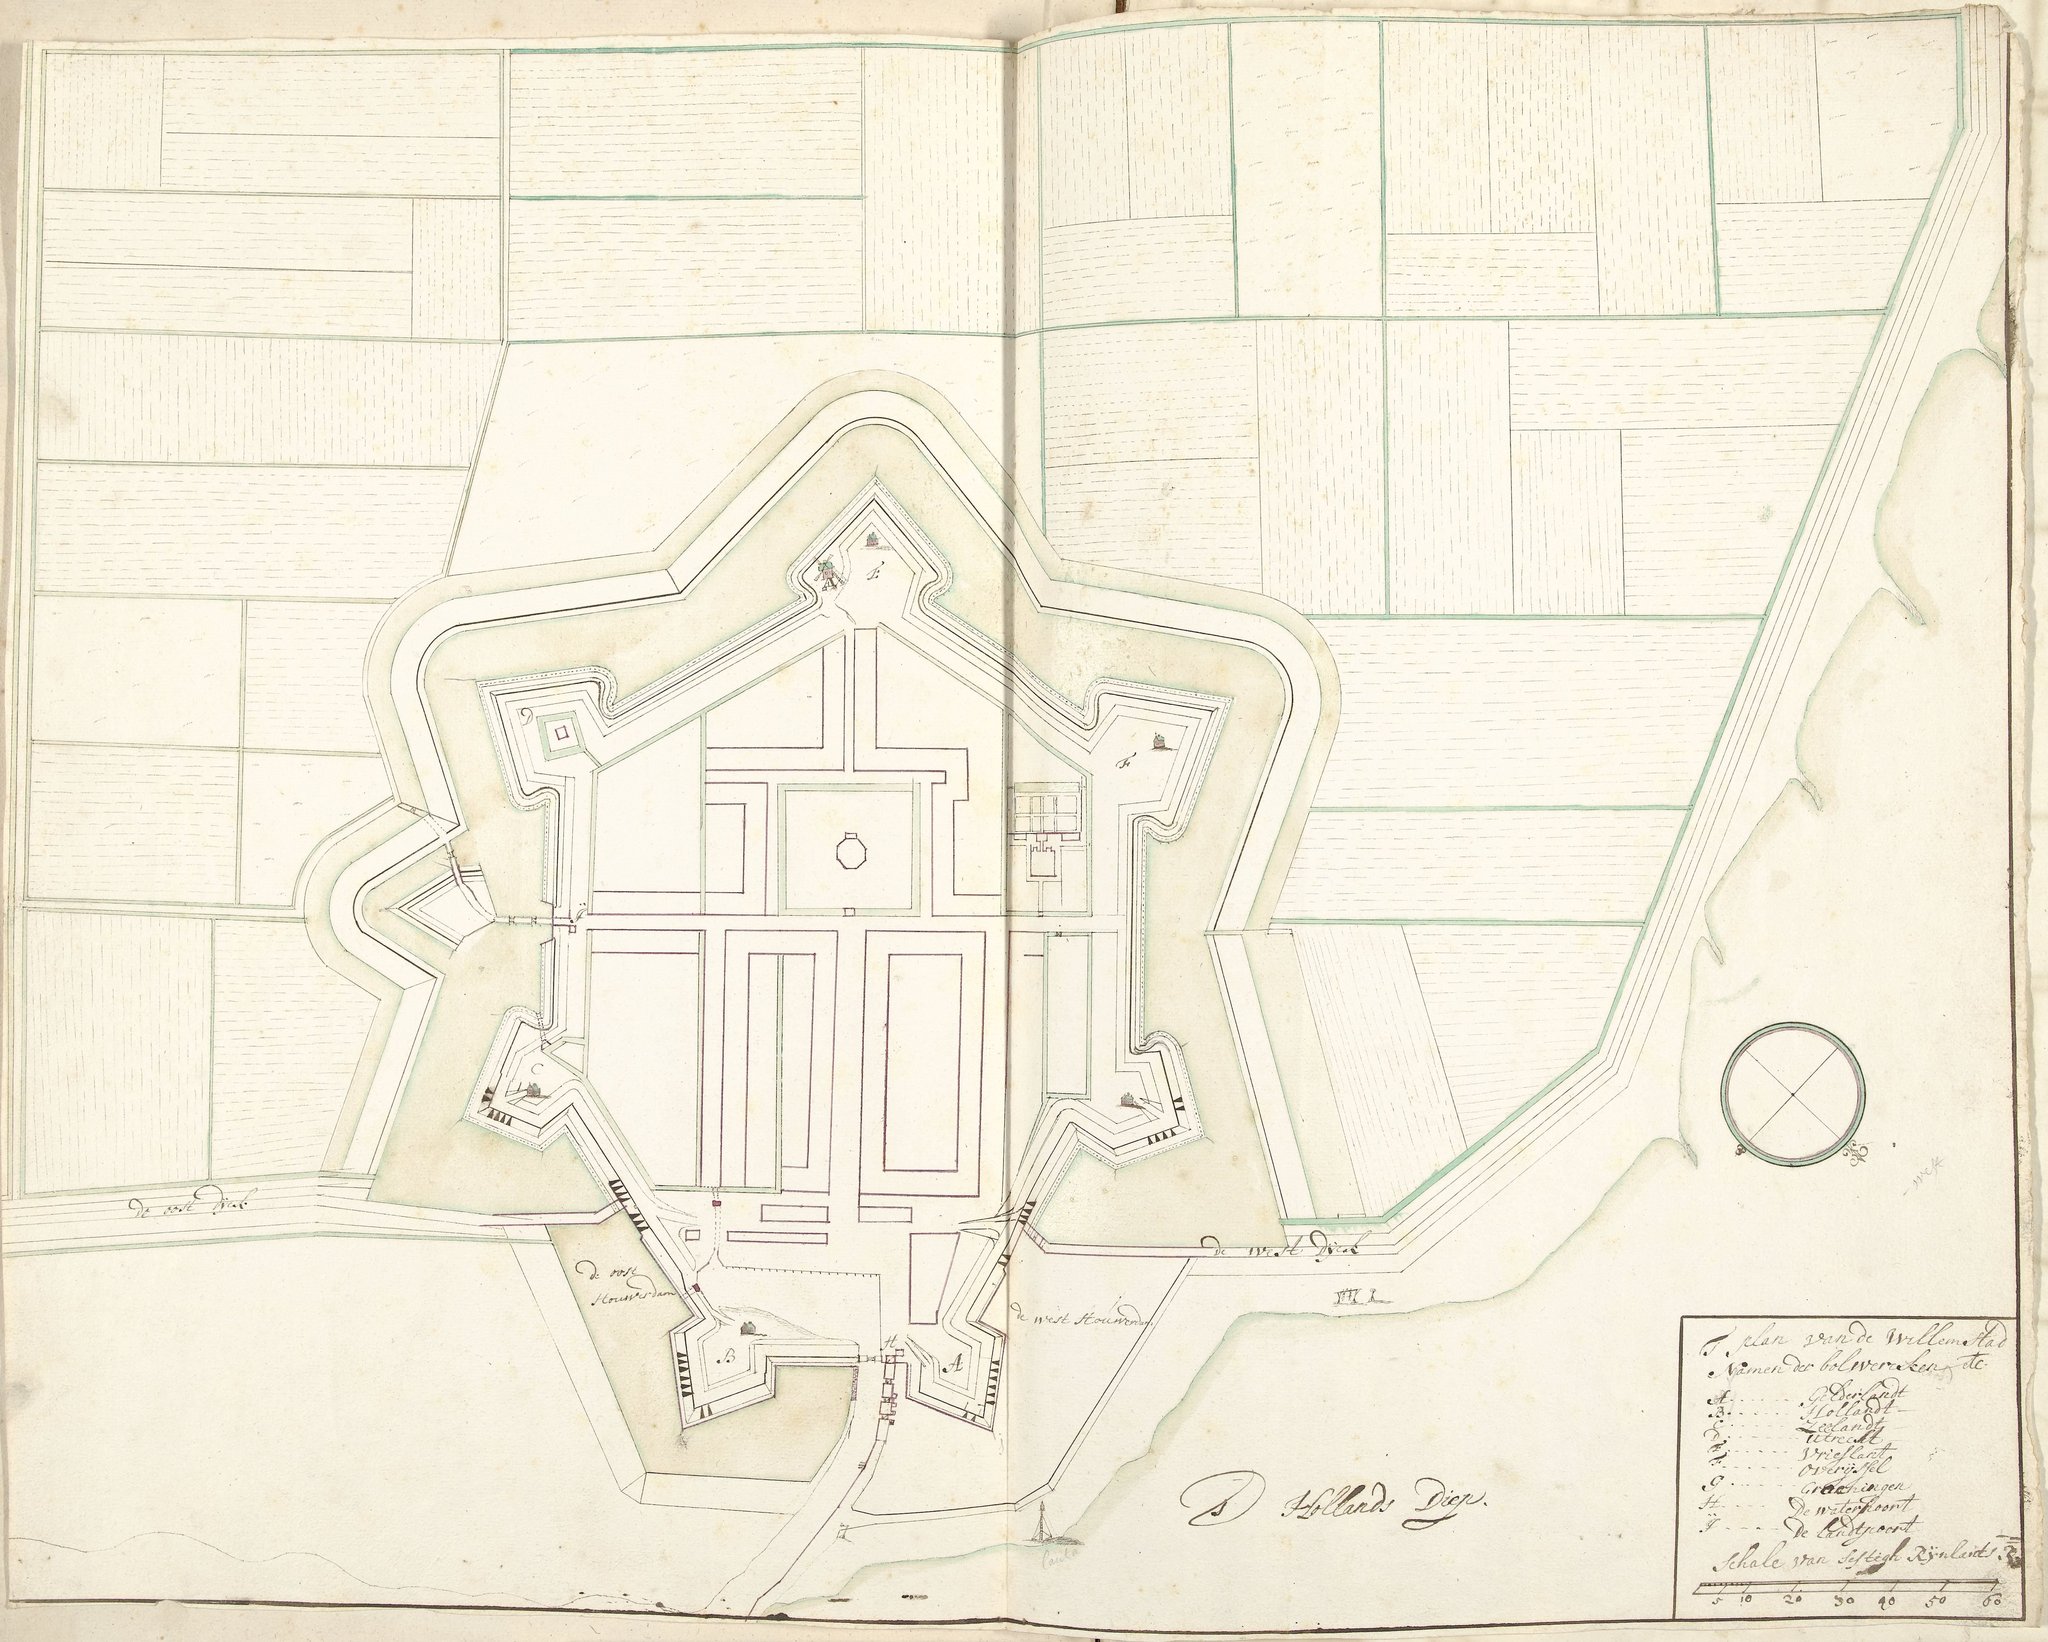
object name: map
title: T plan van de Willemstad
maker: samuel du ry de champdoré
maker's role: draughtsman, engineer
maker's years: 1651-1729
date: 1701-1715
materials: paper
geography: netherlands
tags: fortress, maps of cities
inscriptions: collector's mark: Lugt 2166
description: Plattegrond van de versterkingen om de stad Willemstad, ca. 1701-1715. Rechtsonder de legenda A-I in het Nederlands. Onderdeel van een verzameling getekende plannen van versterkte plaatsen in Nederland en omringende landen ten tijde van de Spaanse Successieoorlog (deel C).